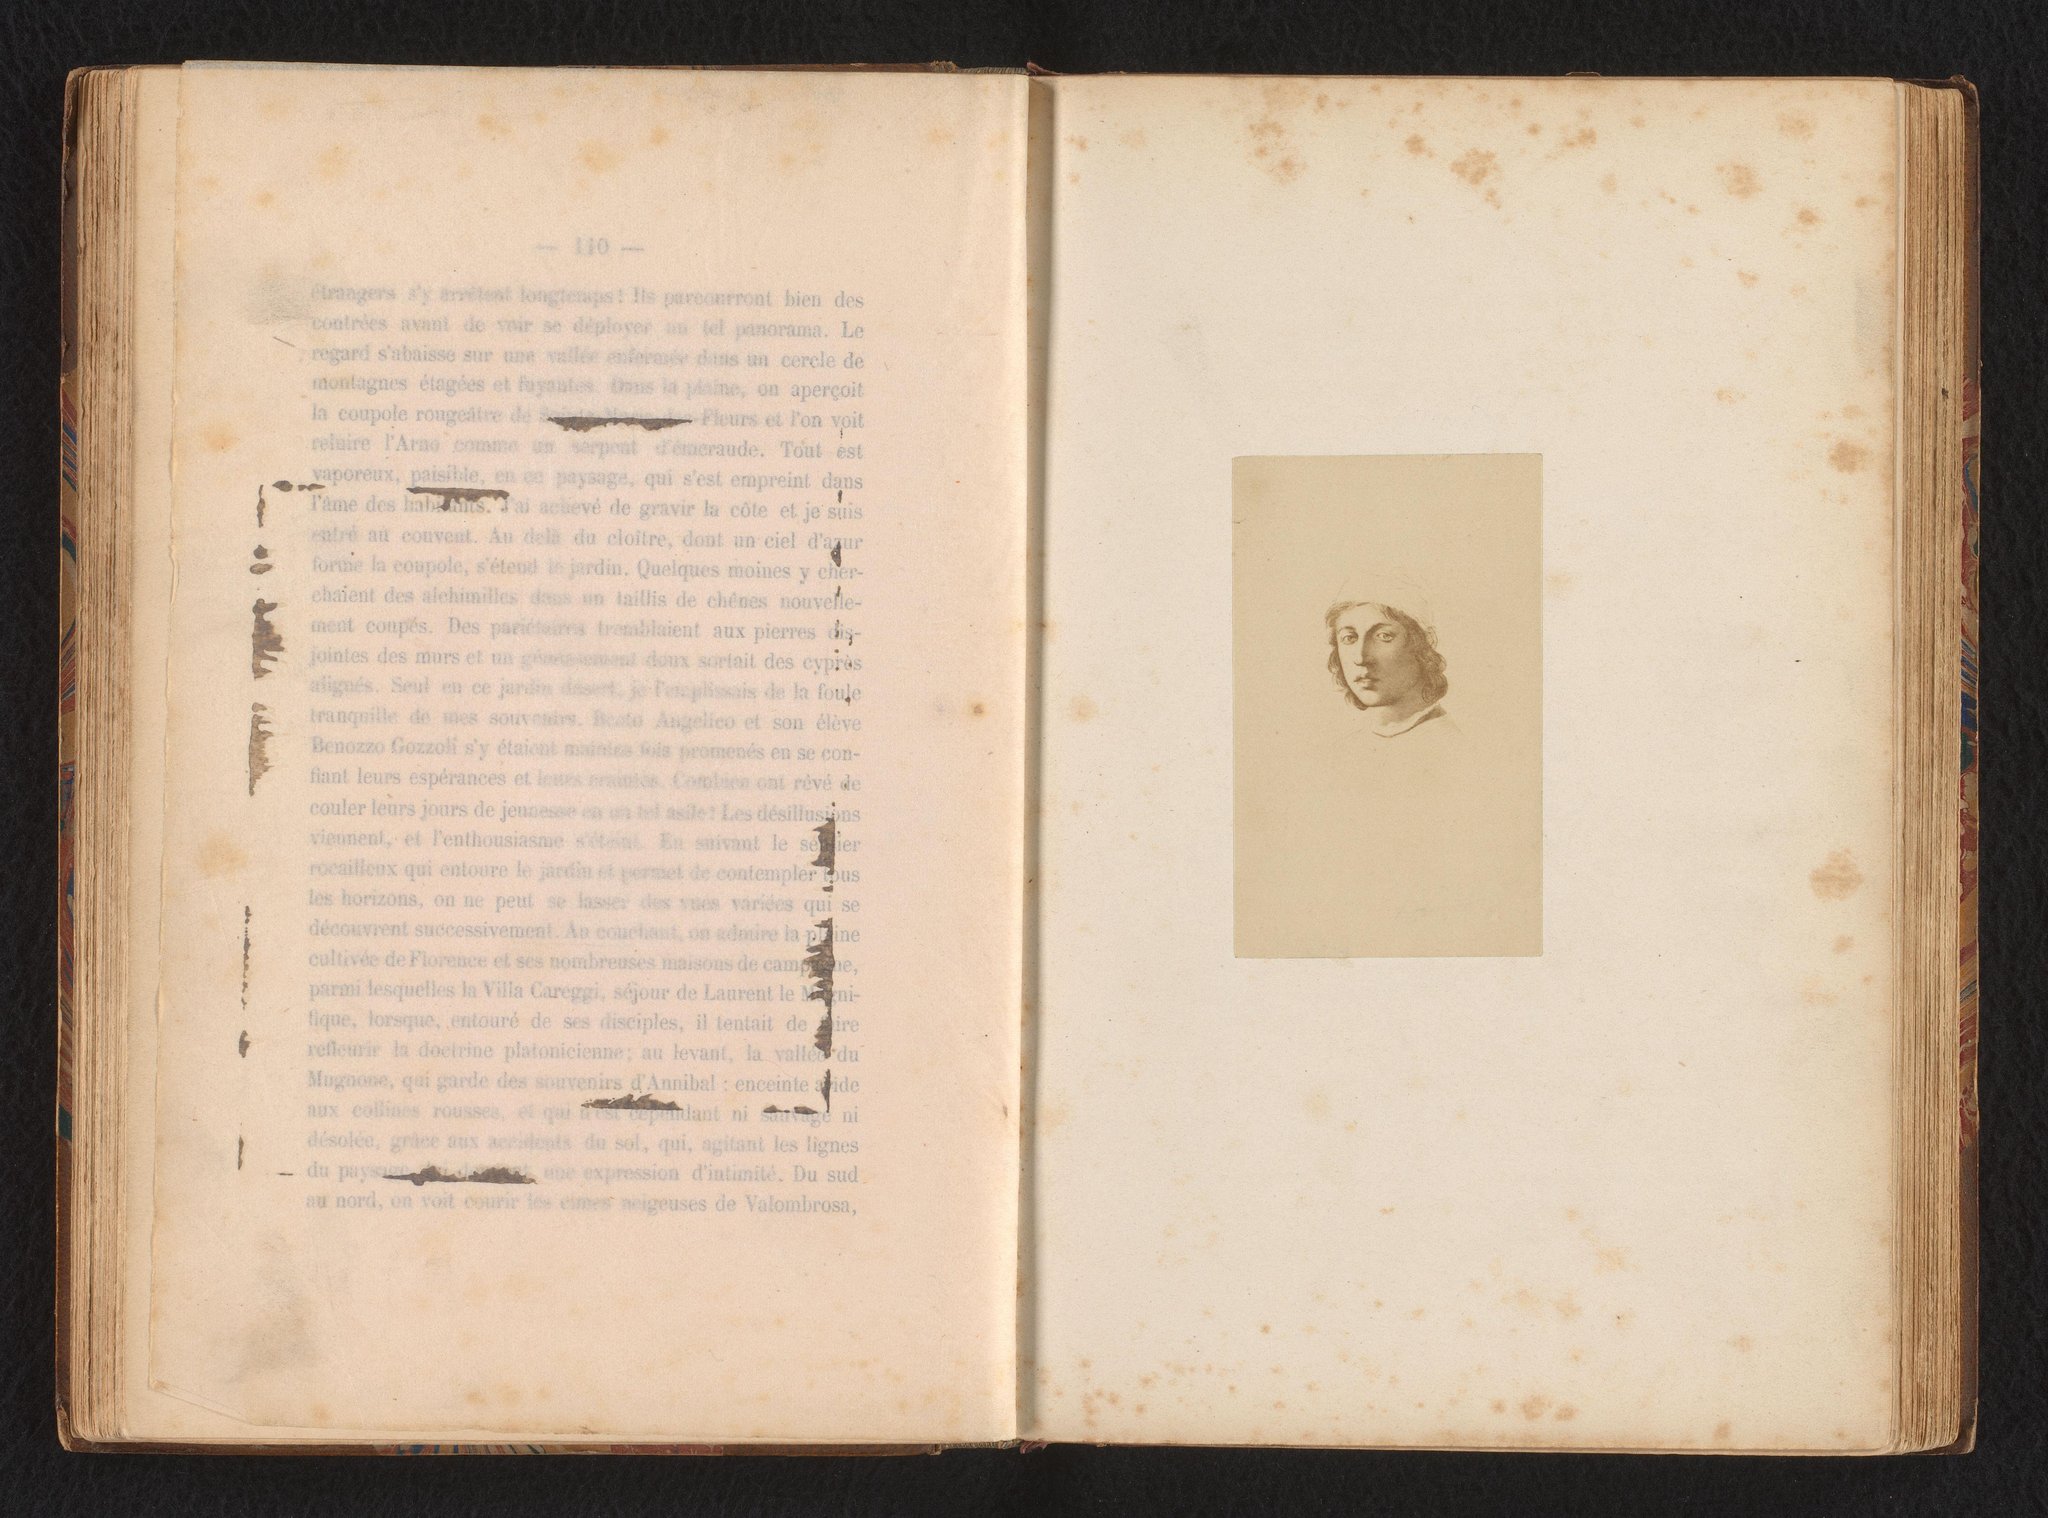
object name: page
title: Fotoreproductie van een getekend portret van een onbekende jonge man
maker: Anonymous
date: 1864-1869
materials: paper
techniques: albumen print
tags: drawing, historical persons, youth, adolescent